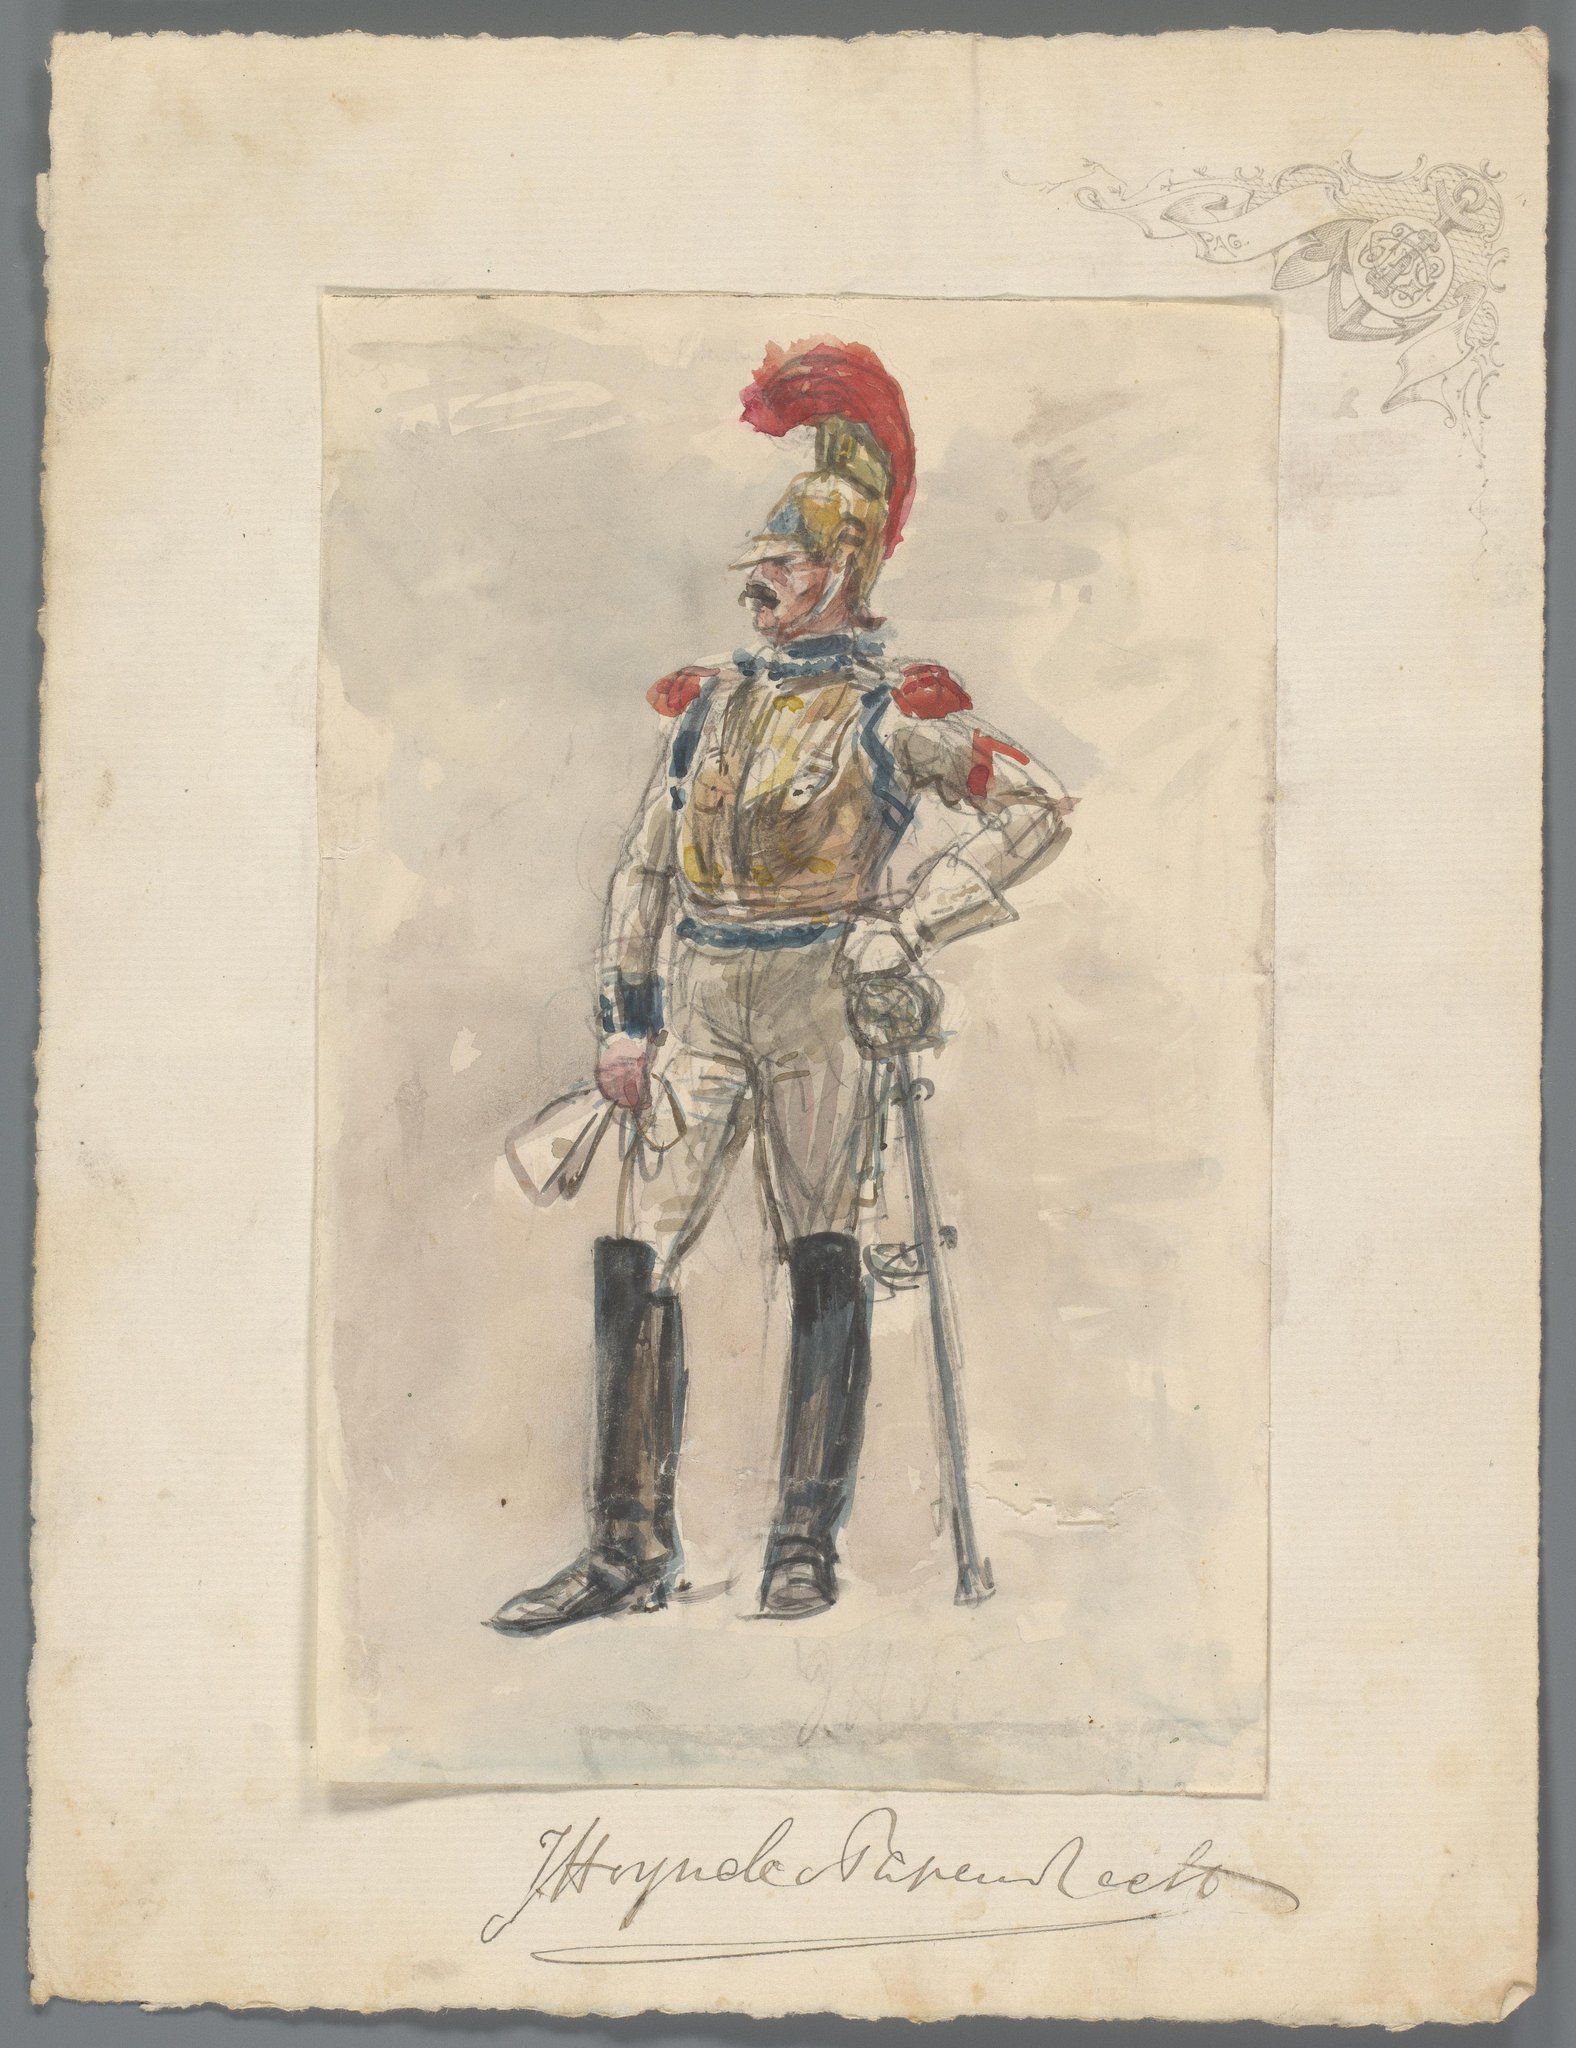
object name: drawing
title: Portret van een onbekende generaal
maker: jan hoynck van papendrecht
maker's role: draughtsman, painter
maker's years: 1858-1933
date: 1894-1919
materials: paper, pencil, watercolor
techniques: brush, lithograph, pen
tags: commander-in-chief, general, marshal, anonymous historical person portrayed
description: Tekening op een blad met gepersonaliseerde decoratie in de vorm van een anker met monogram, met ruimte voor een paginanummer.